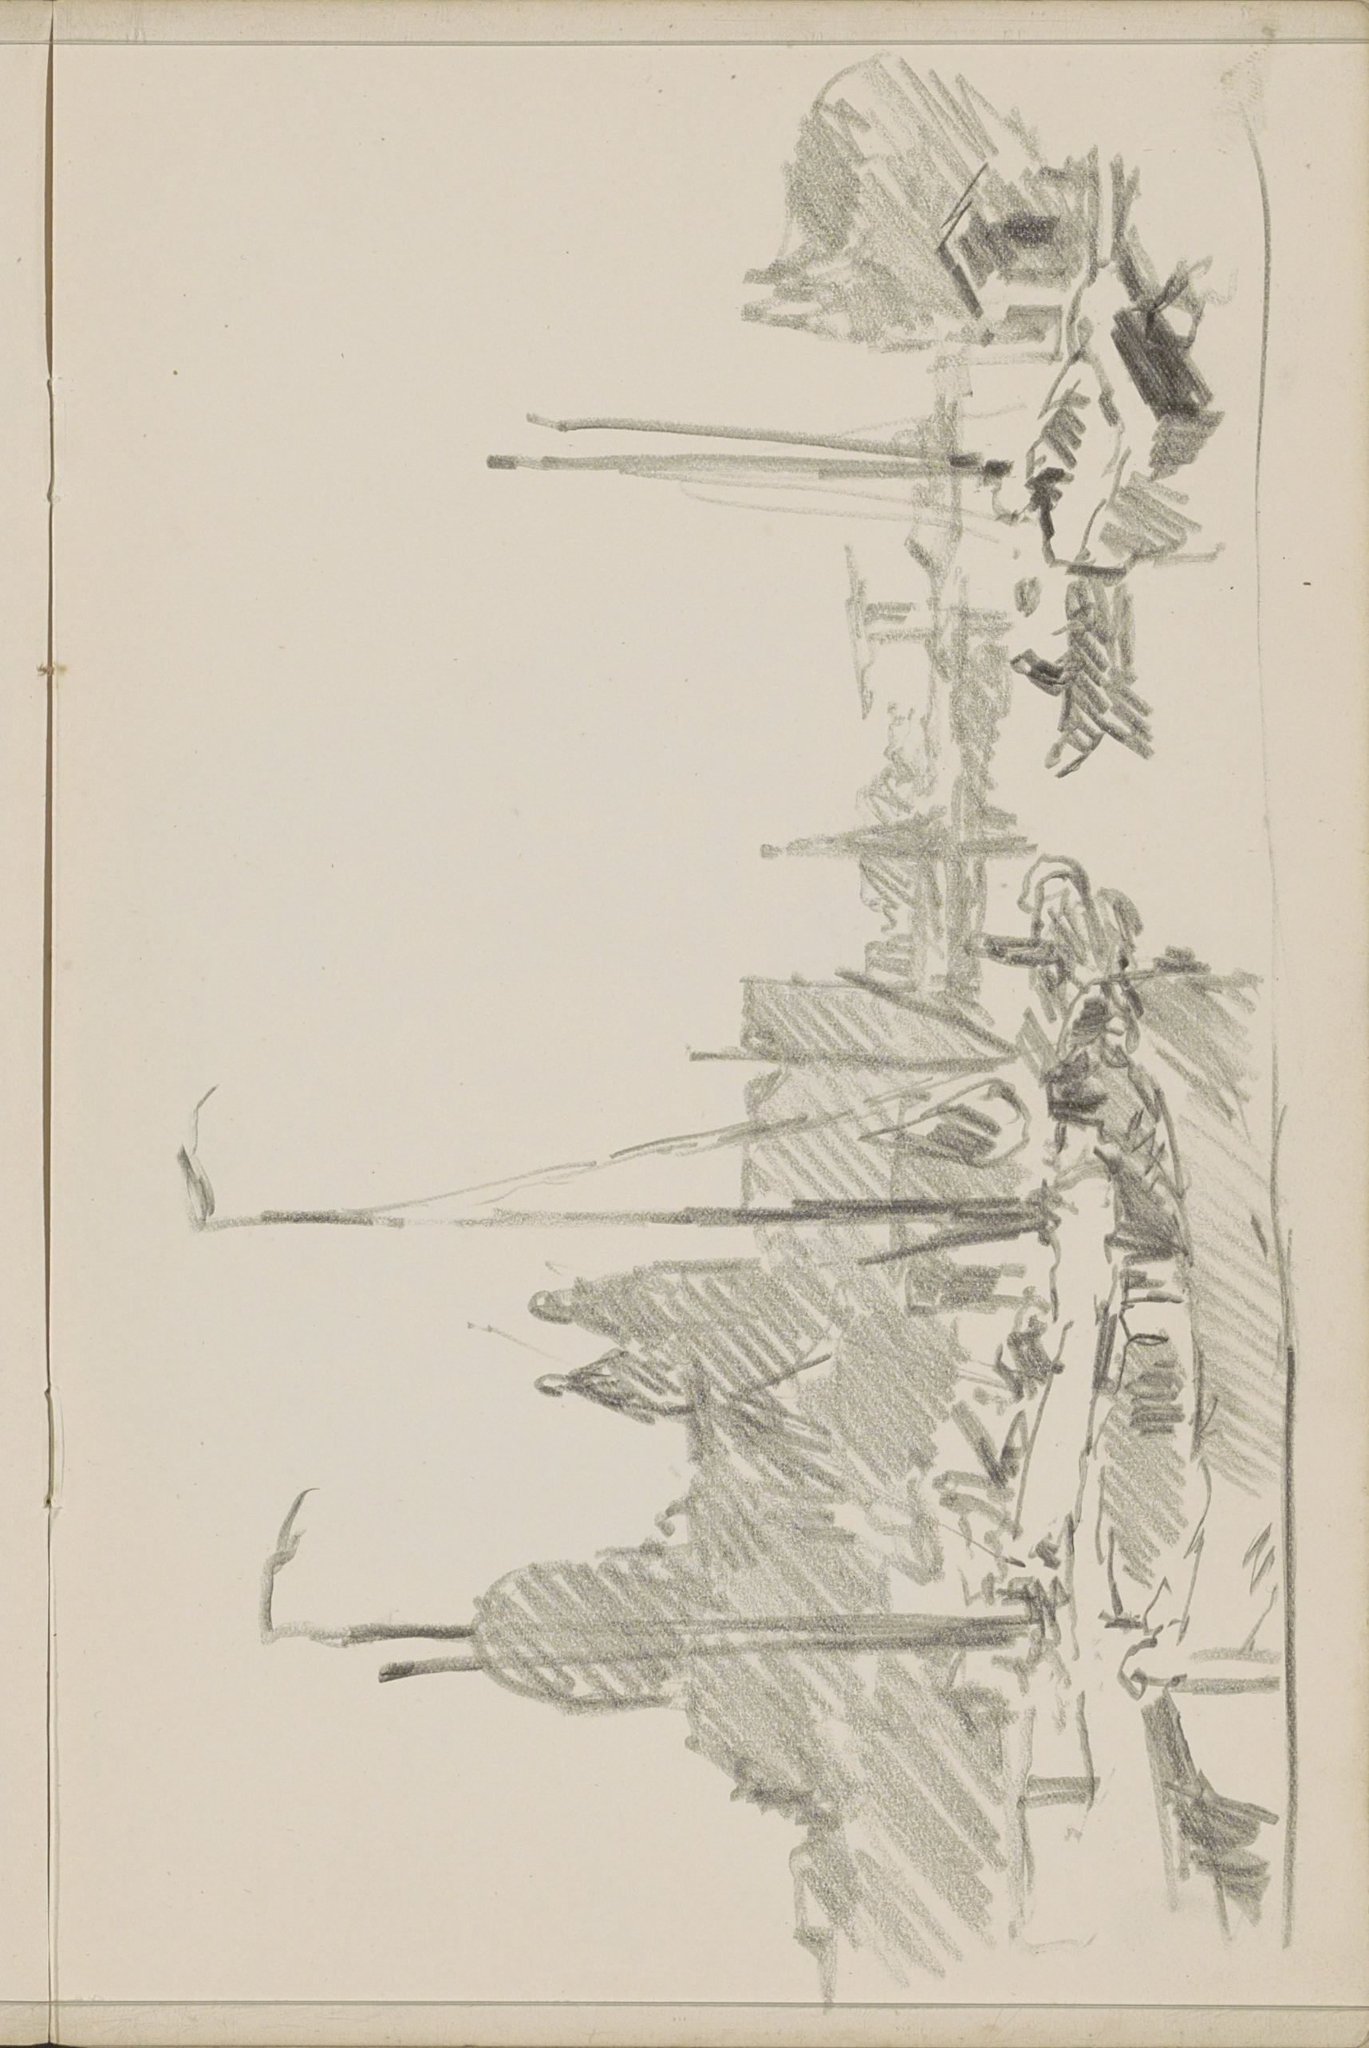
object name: sketchbook leaf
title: Schepen op de Oudezijds Kolk bij de Nicolaaskerk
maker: cornelis vreedenburgh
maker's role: draughtsman, print maker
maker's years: 1880-1946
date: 1890-1946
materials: paper, pencil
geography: amsterdam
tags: church (exterior), canals, waters (in city)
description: Blad 7 recto uit een schetsboek met 47 bladen.